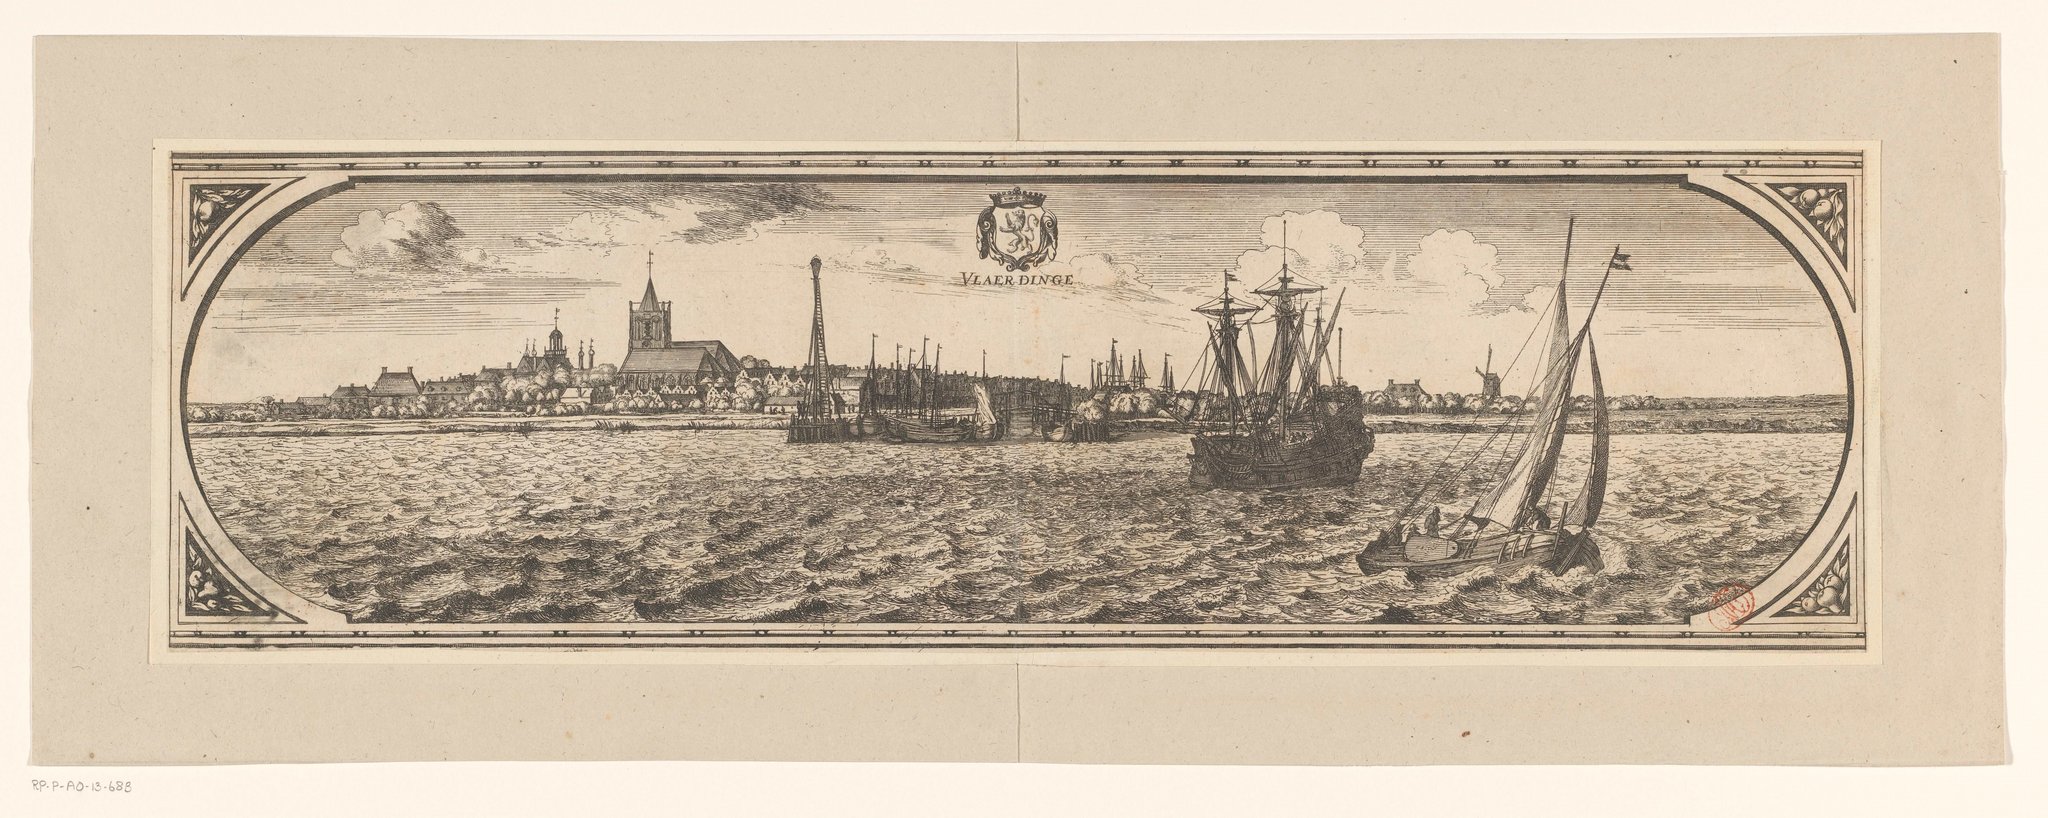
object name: print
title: Vlaerdinge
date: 1666-1698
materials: paper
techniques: engraving, etching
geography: rotterdam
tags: coat of arms (as symbol of the state, etc.) (+ city; municipal), sailing-ship, sailing-boat, church (exterior), townhall, windmill, prospect of city, town panorama, silhouette of city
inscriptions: collector's mark: Lugt 195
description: Gezicht op Vlaardingen gezien vanaf het water. Links het stadhuis en rechts daarvan de Grote Kerk. In het water verschillende zeilschepen. Boven in het midden het wapen van de stad en de titel.